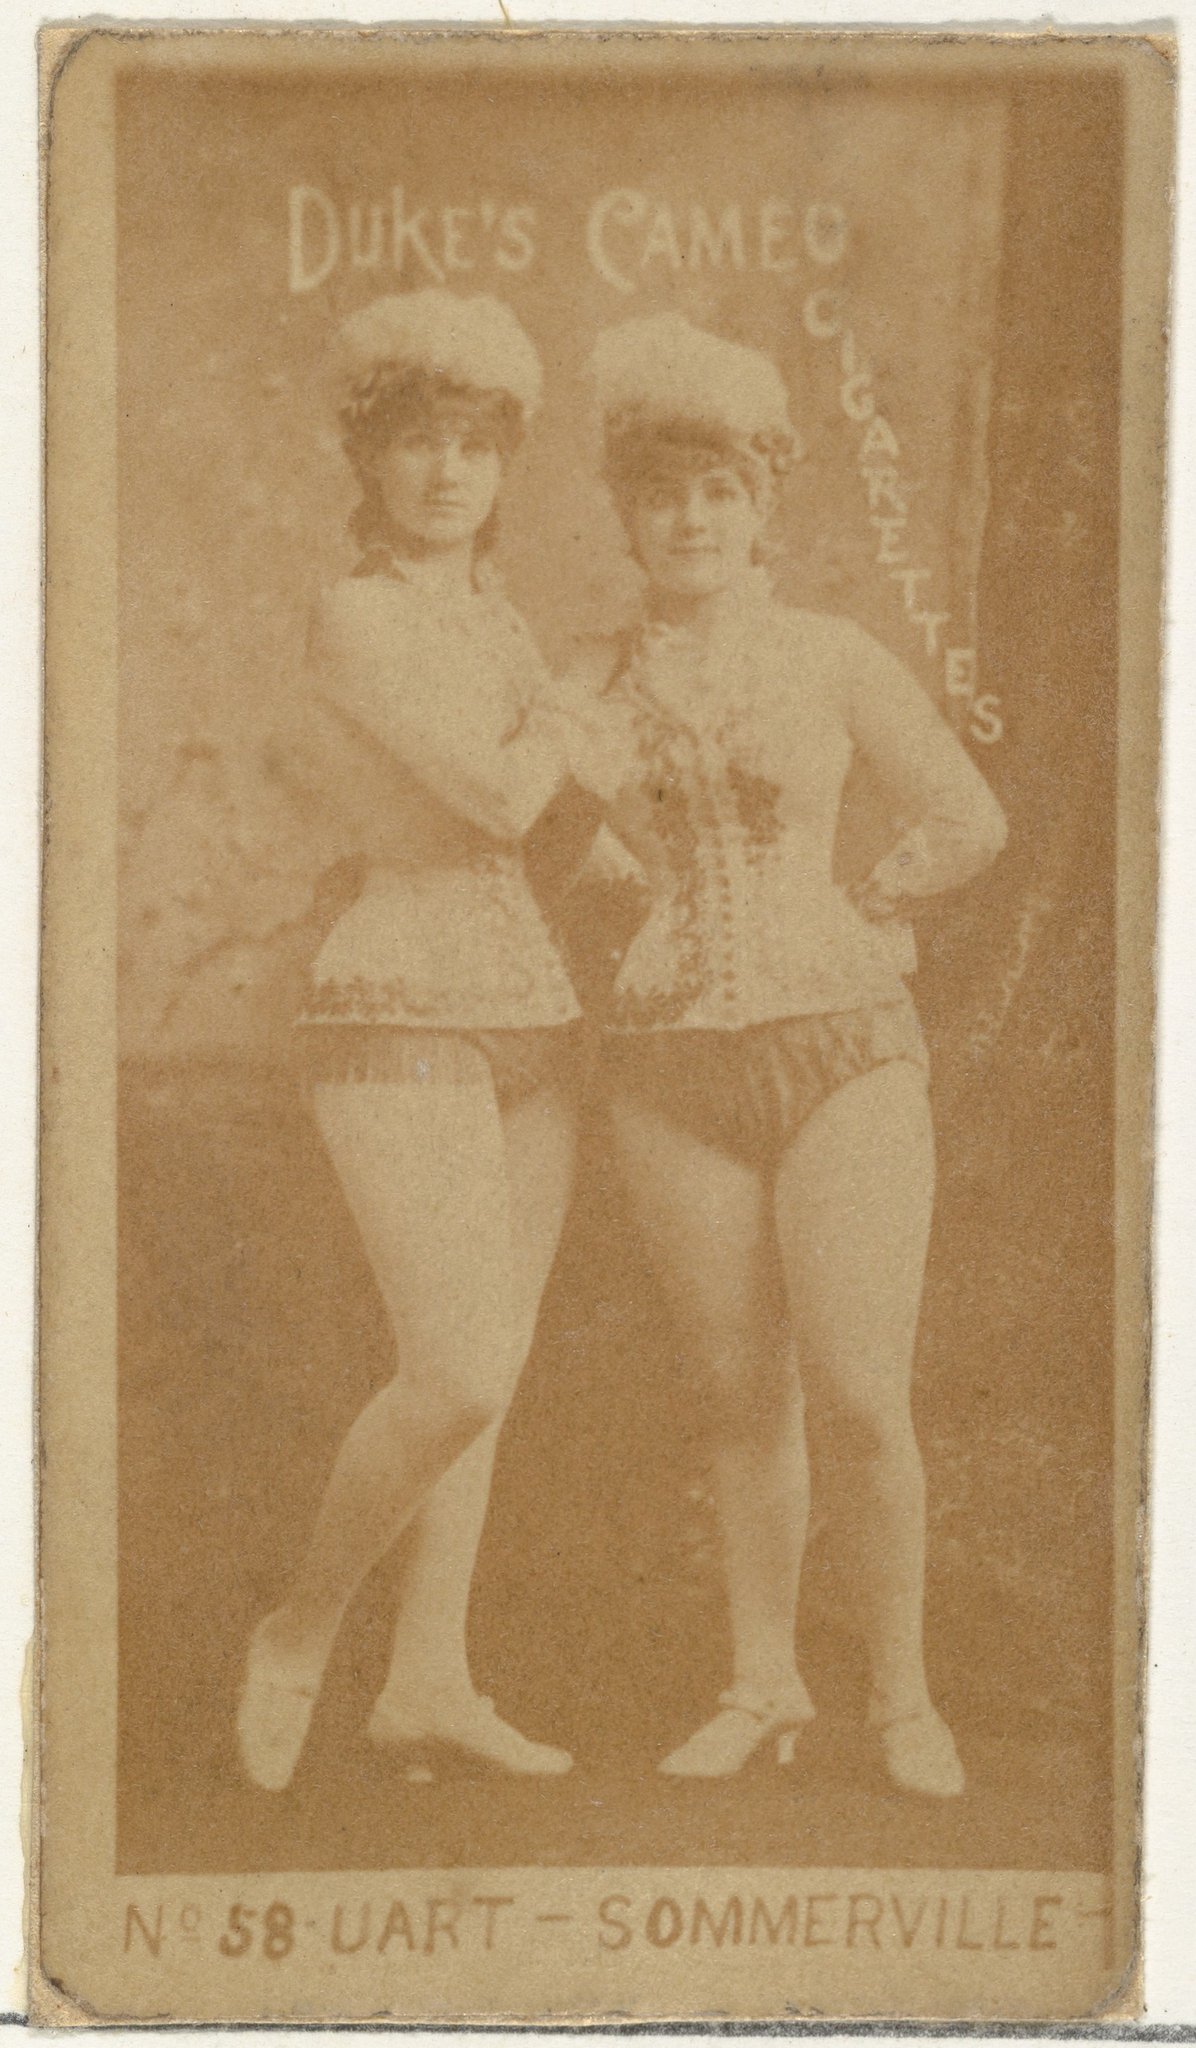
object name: photograph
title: Card Number 58, Uart and Sommerville, from the Actors and Actresses series (N145-4) issued by Duke Sons & Co. to promote Cameo Cigarettes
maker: w. duke, sons & co.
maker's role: publisher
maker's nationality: american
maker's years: 1870-1920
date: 1880-1889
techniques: albumen silver print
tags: portraits,women,actresses